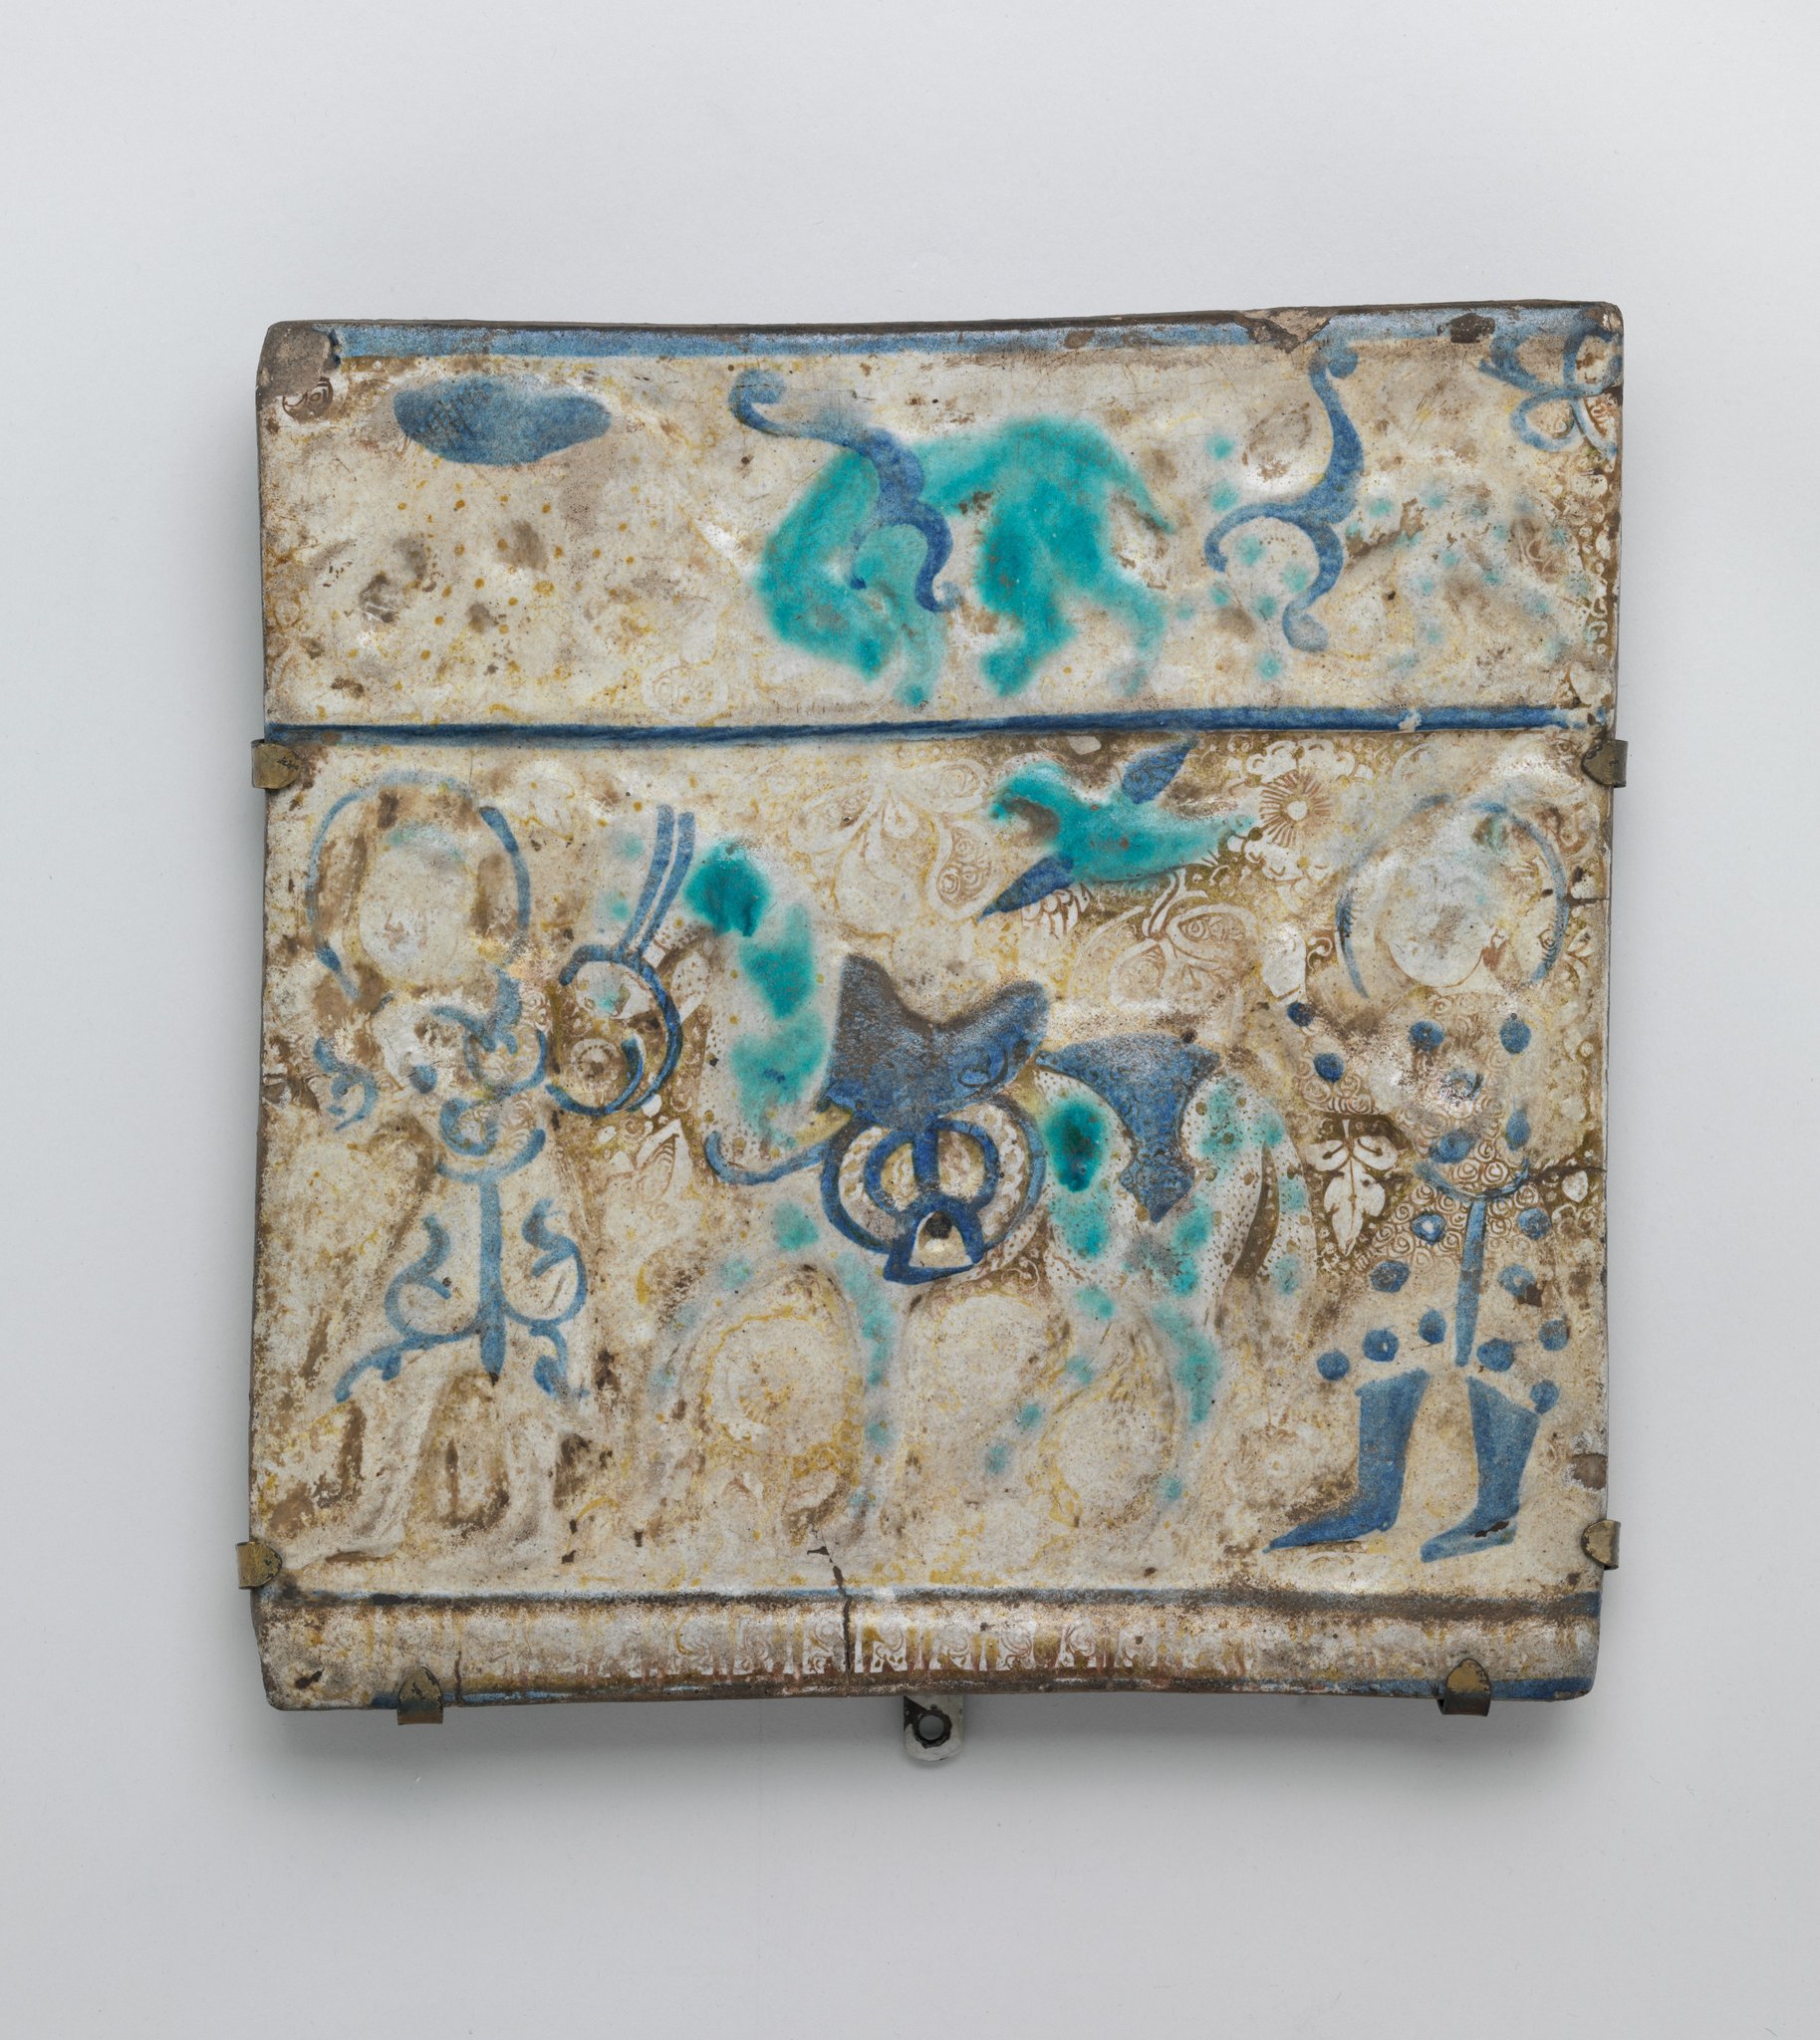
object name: tile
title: Square Tile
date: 1267-1300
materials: glaze, stonepaste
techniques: luster painting, molding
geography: iran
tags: human figures,birds,horses